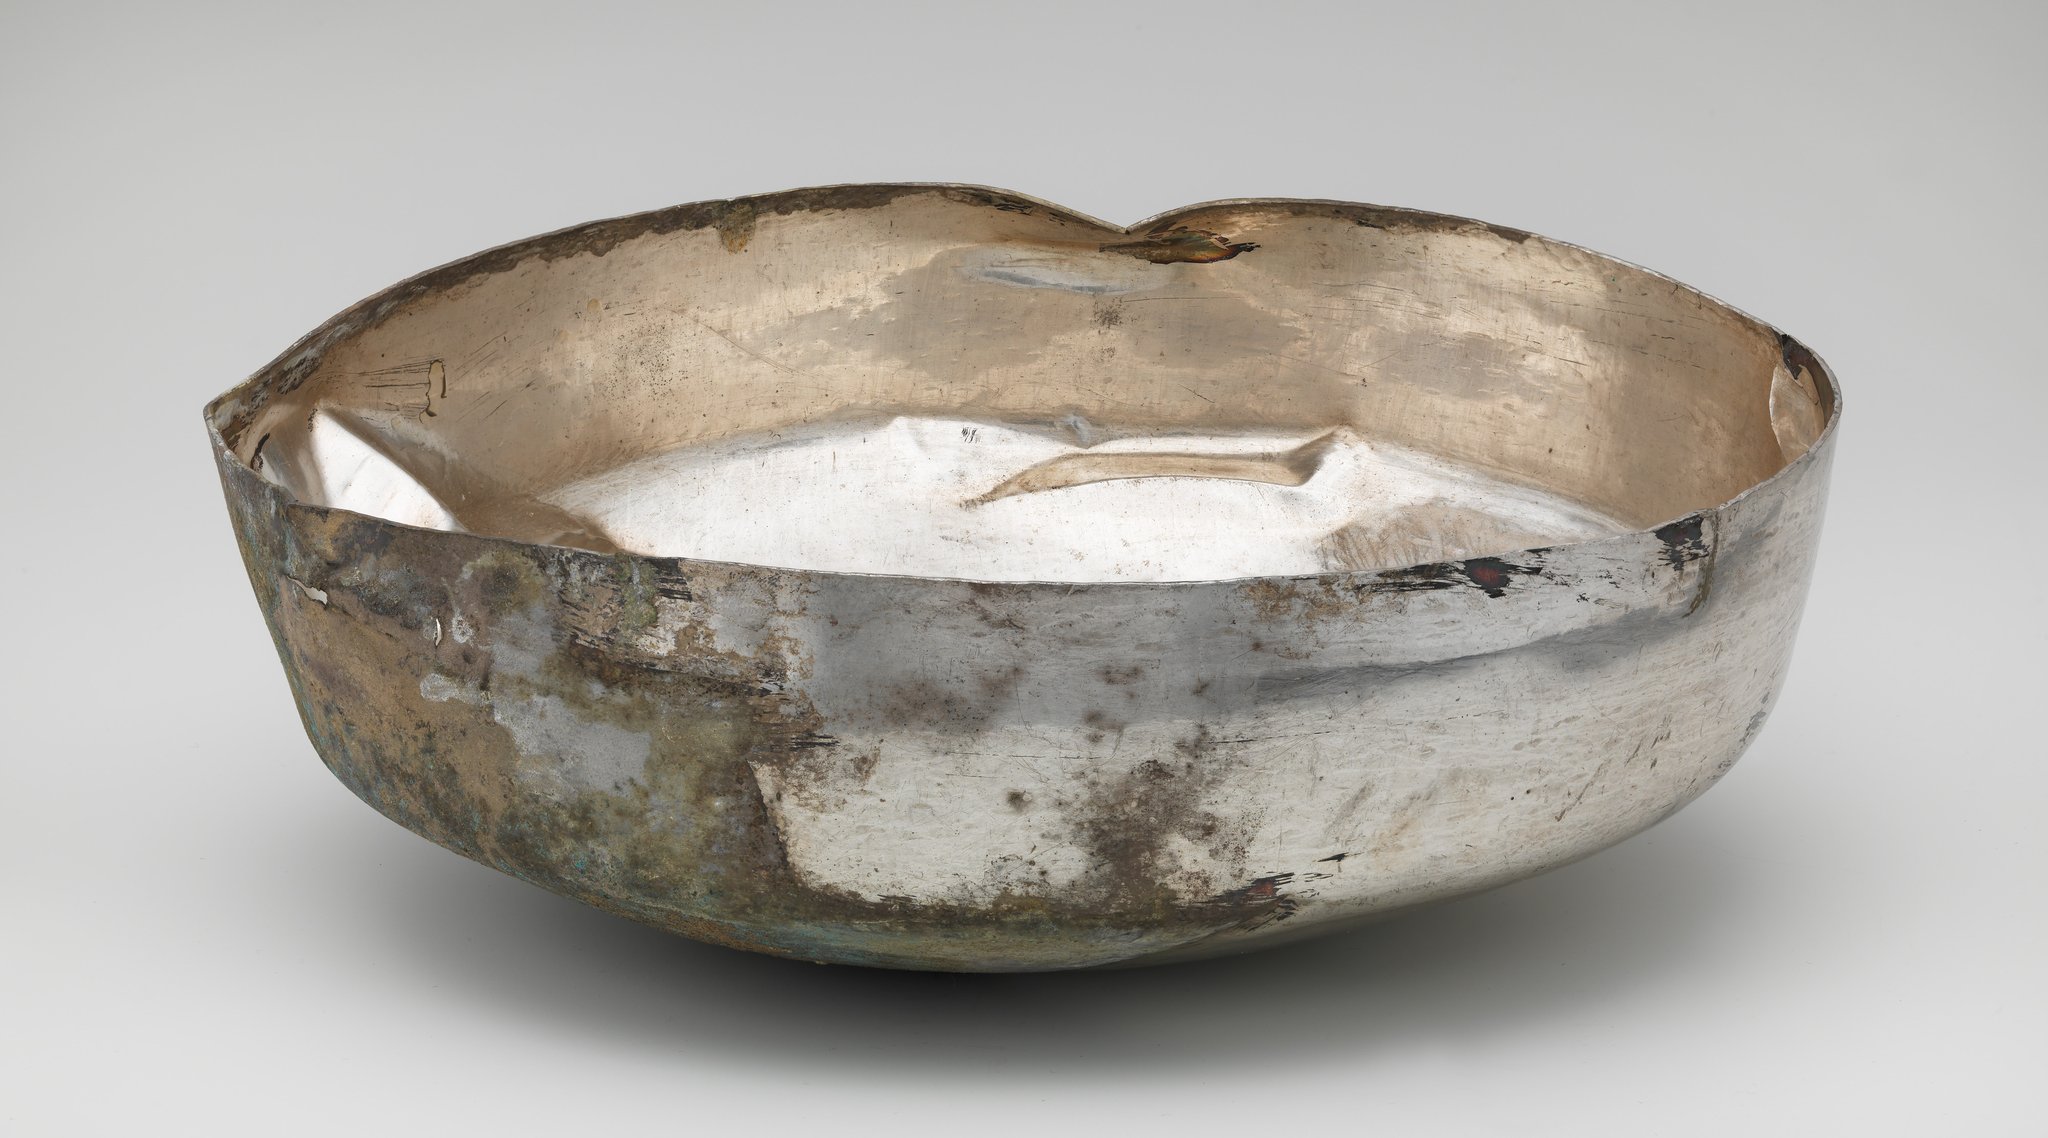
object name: bowl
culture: chimú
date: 1101-1500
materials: silver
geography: peru